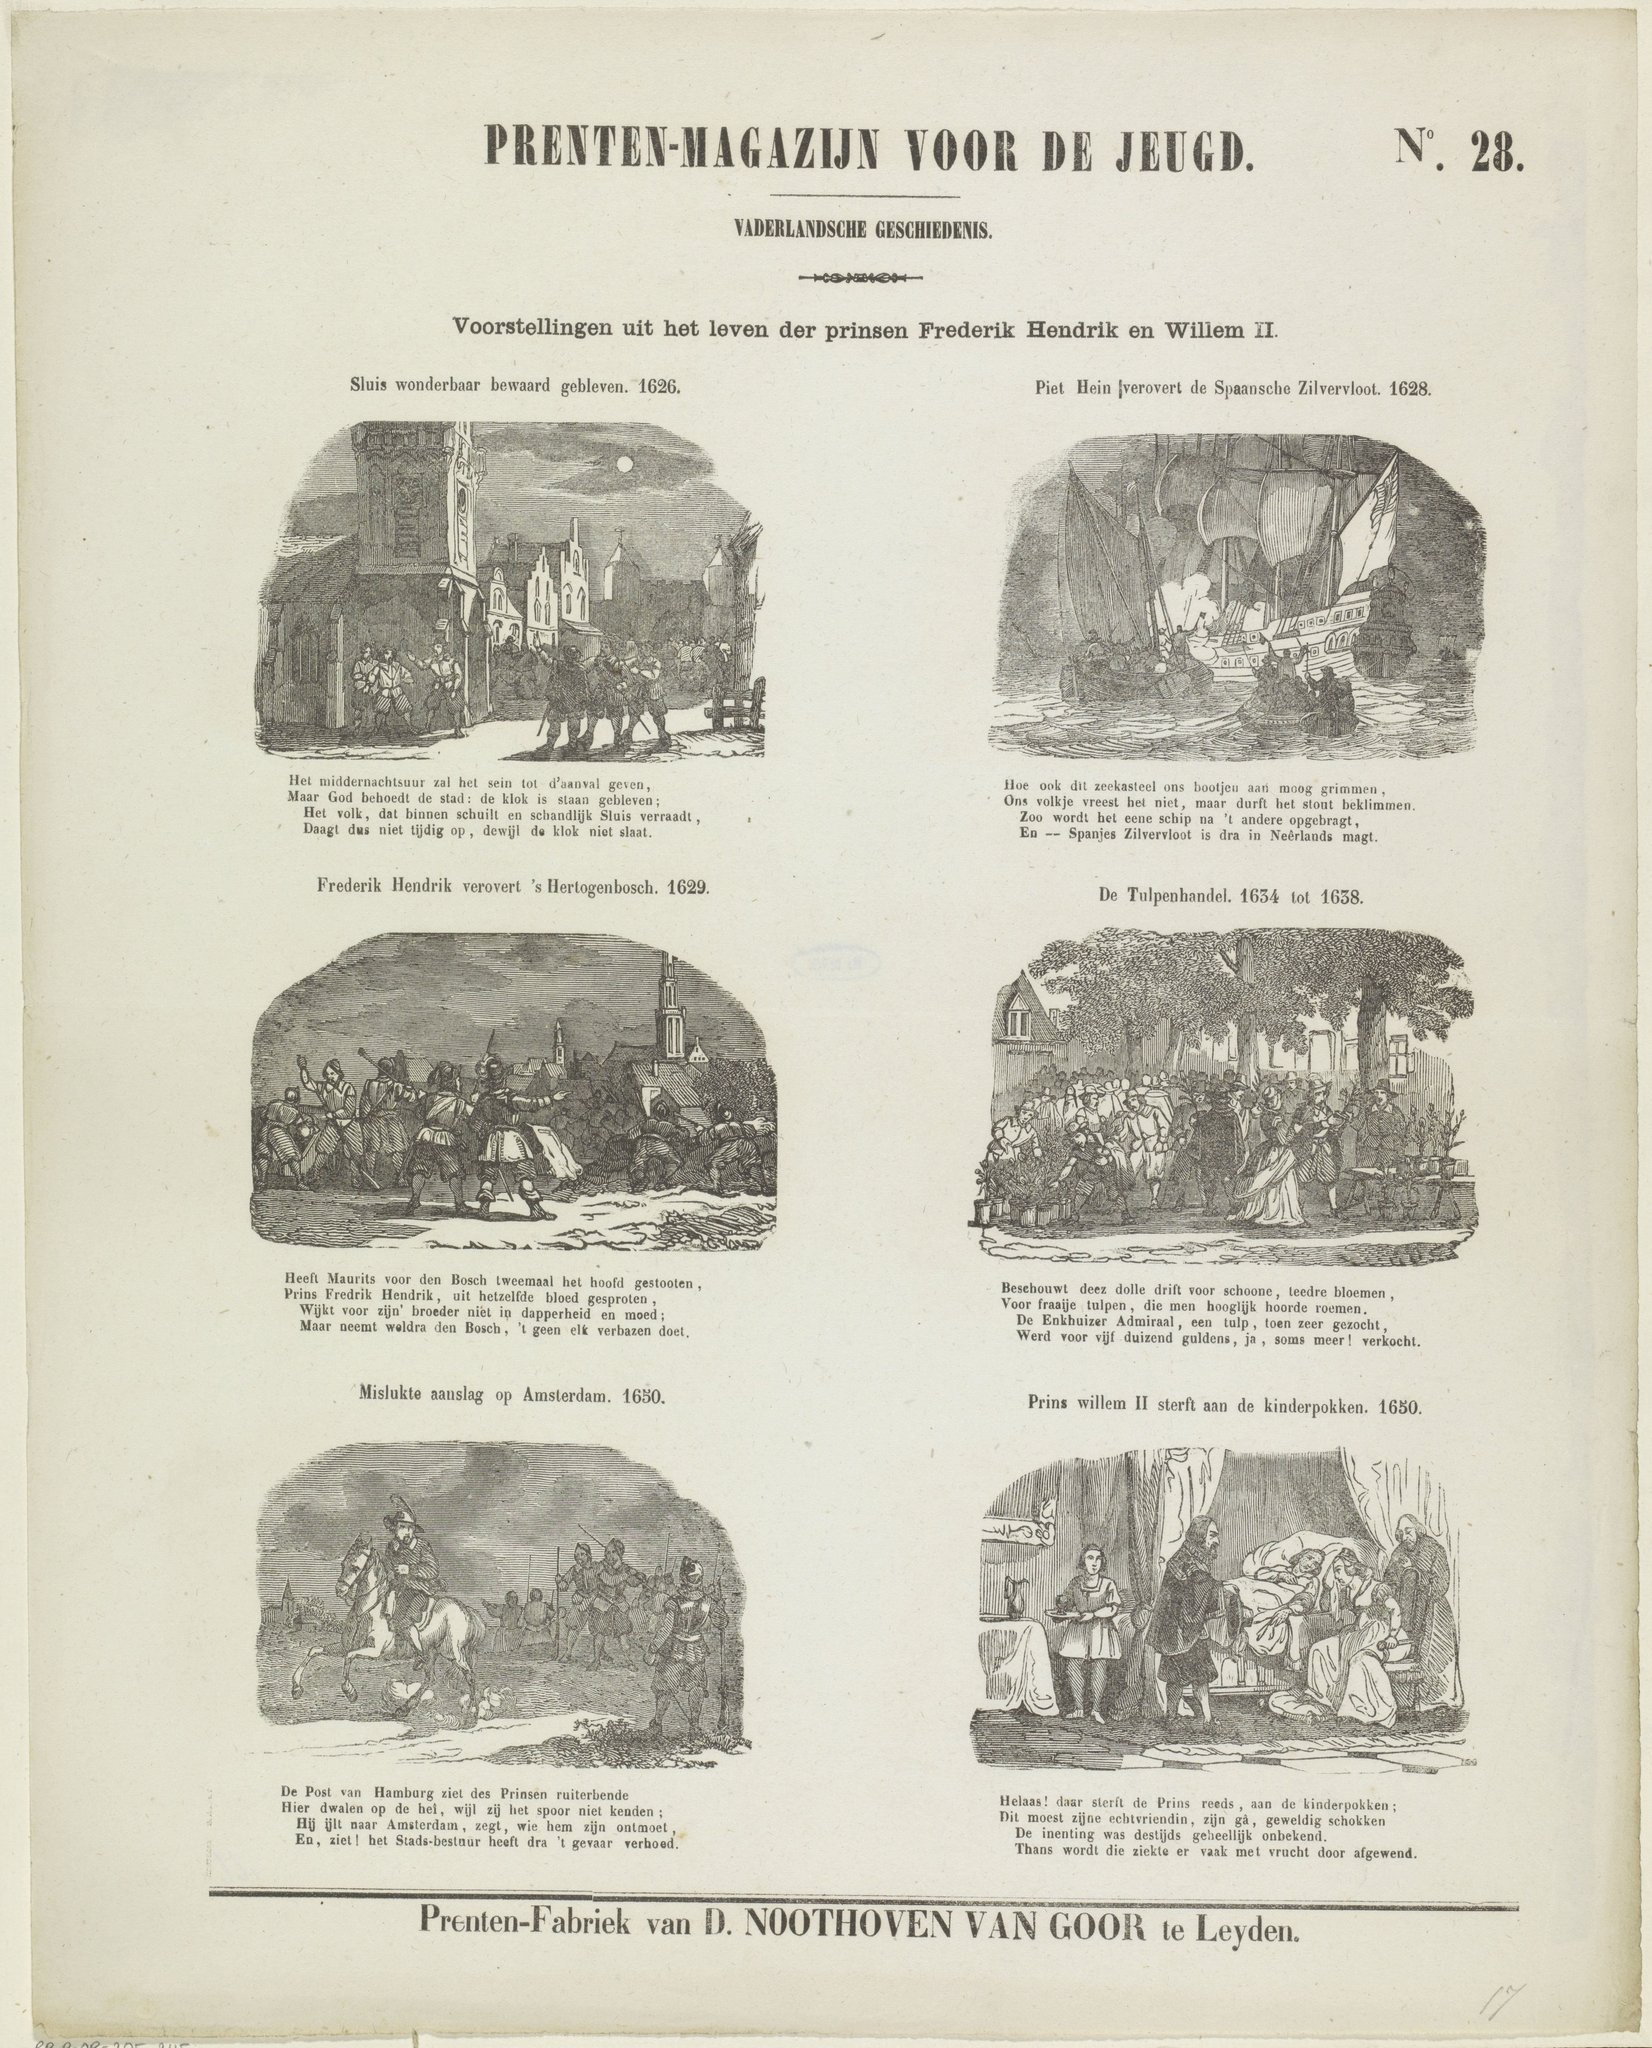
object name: popular print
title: Voorstellingen uit het leven der prinsen Frederik Hendrik en Willem II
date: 1850-1881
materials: paper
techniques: letterpress printing, engraving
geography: leiden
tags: delfshaven, william ii (prince of orange), history, den bosch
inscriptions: collector's mark: Lugt 2228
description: Blad met 6 voorstellingen van gebeurtenissen uit de vaderlandse geschiedenis. Boven elke voorstelling een titel en onder elke voorstelling een vierregelig vers. Genummerd rechtsboven: No. 28.